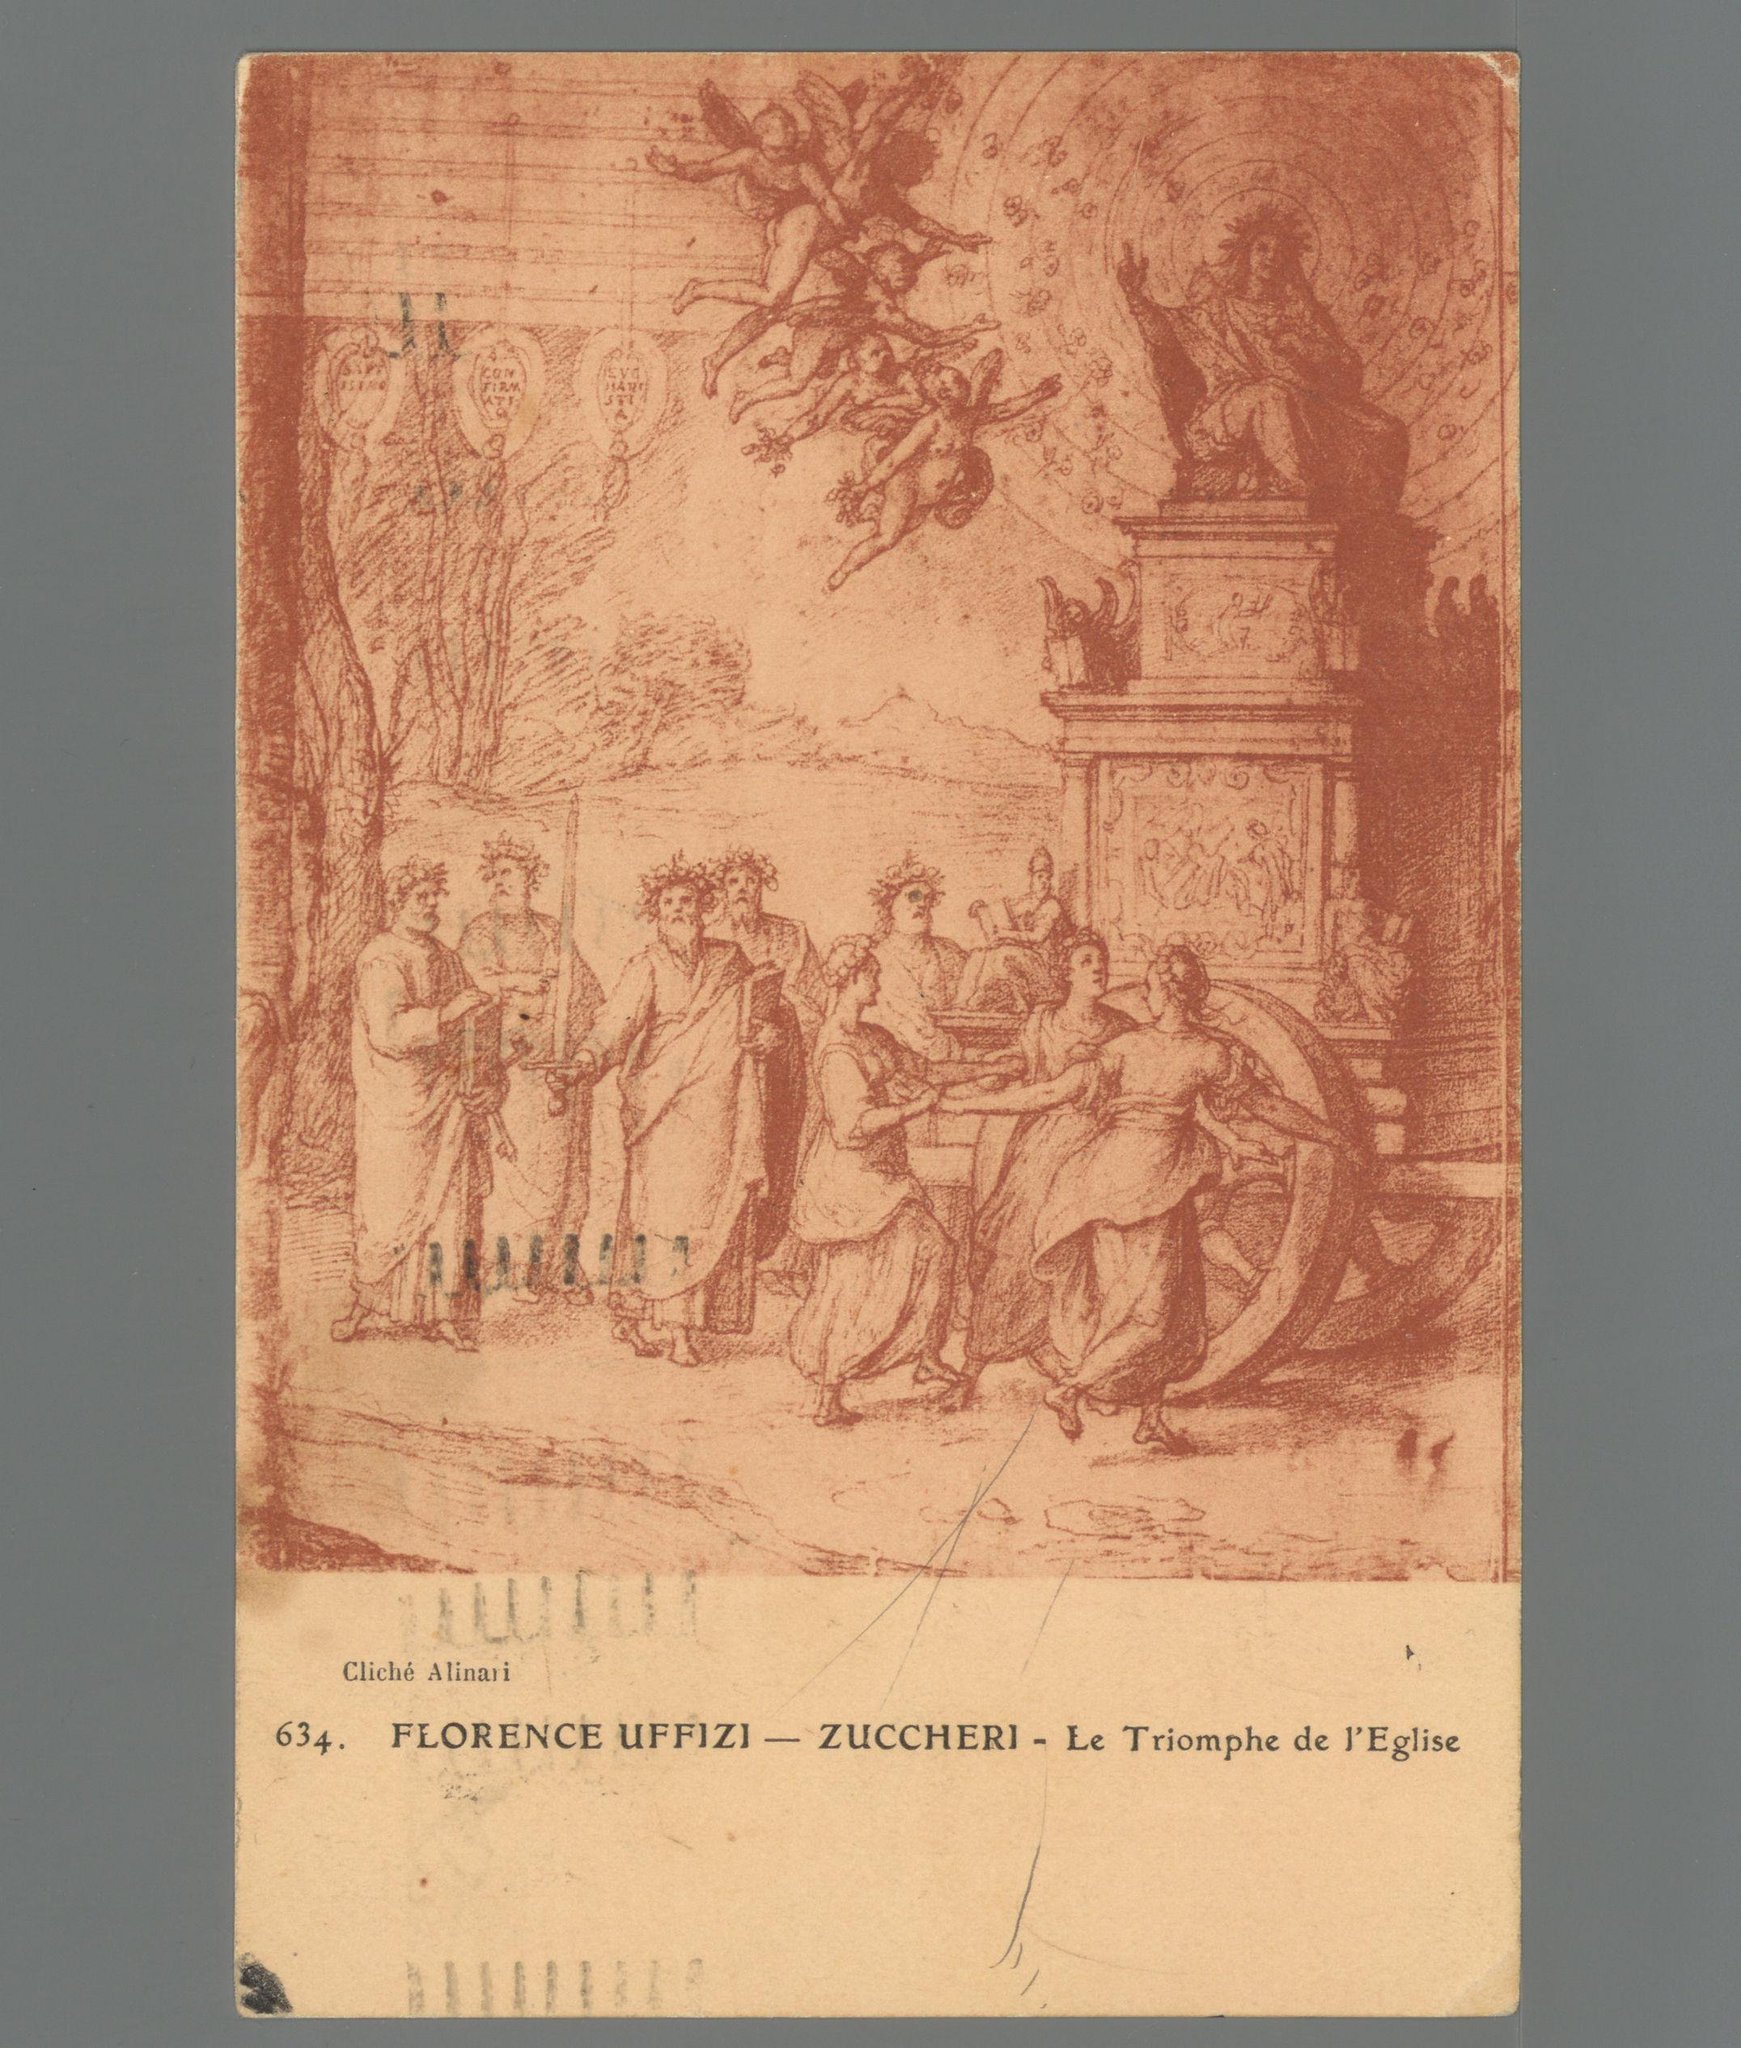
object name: reproduction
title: Florence Uffizi. Zuccheri. Le Triomphe de l'Eglise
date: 1906-1922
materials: cardboard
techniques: photograph, writing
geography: florence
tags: god the father (+ angel(s)), landscapes - hh - ideal landscapes (+ landscape with figures, staffage)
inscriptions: collector's mark: ‘AFE v S’, postage stamp